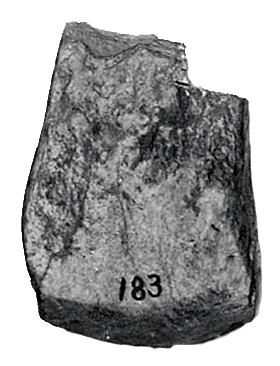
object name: hatchet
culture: swiss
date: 1902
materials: jade